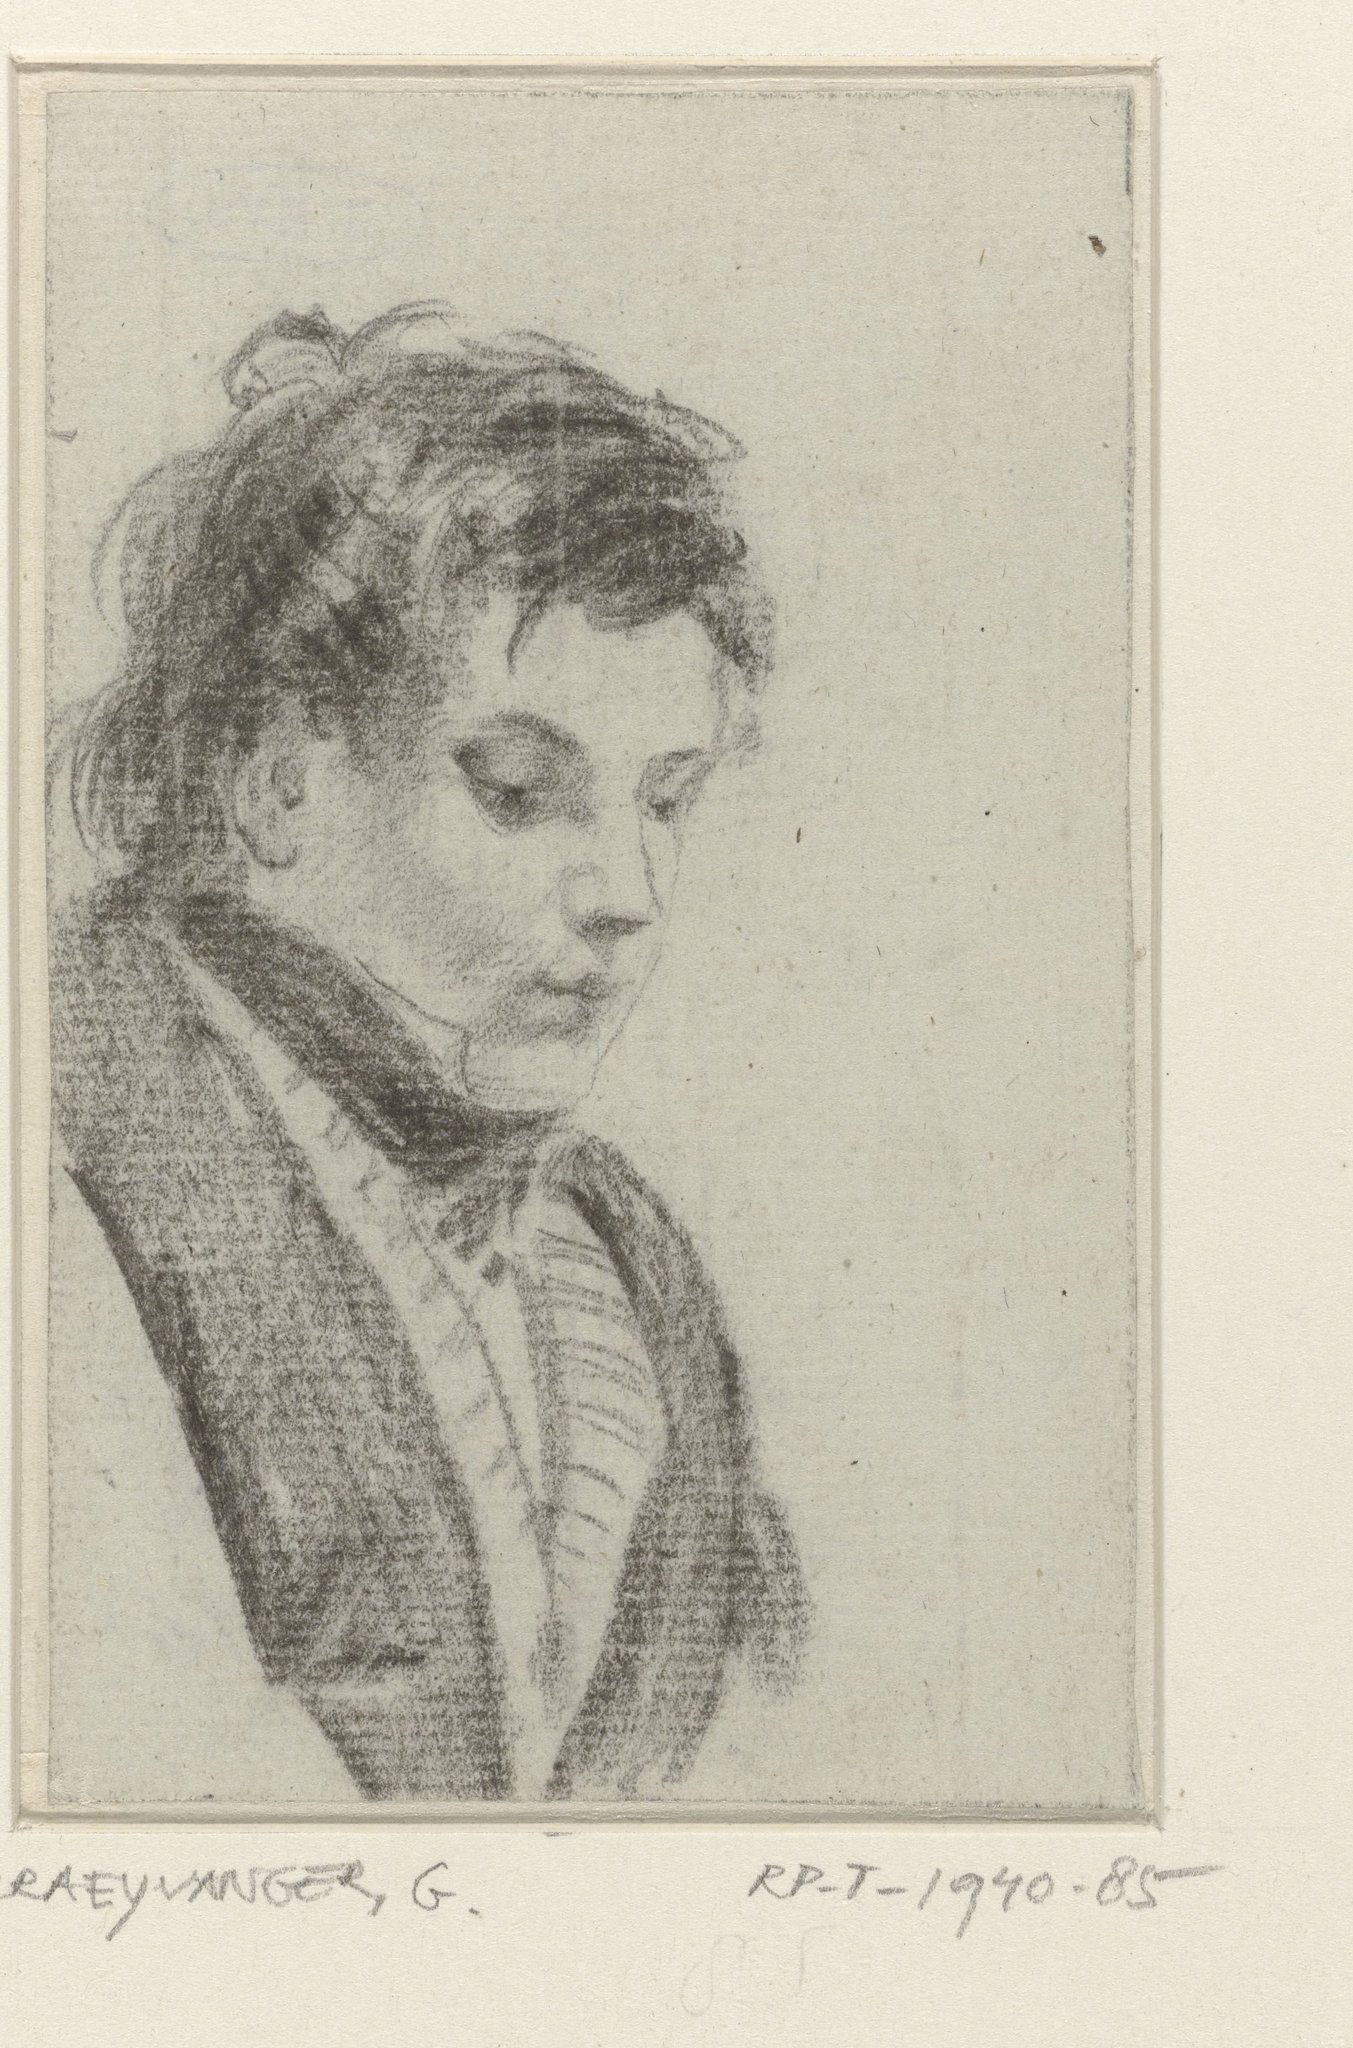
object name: drawing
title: Portret van Johannes de Mare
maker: gijsbertus craeyvanger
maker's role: draughtsman, print maker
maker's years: 1810-1895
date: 1820-1895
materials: chalk, paper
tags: amsterdam, print maker, draughtsman, johannes de mare, historical persons, portrait, self-portrait of artist